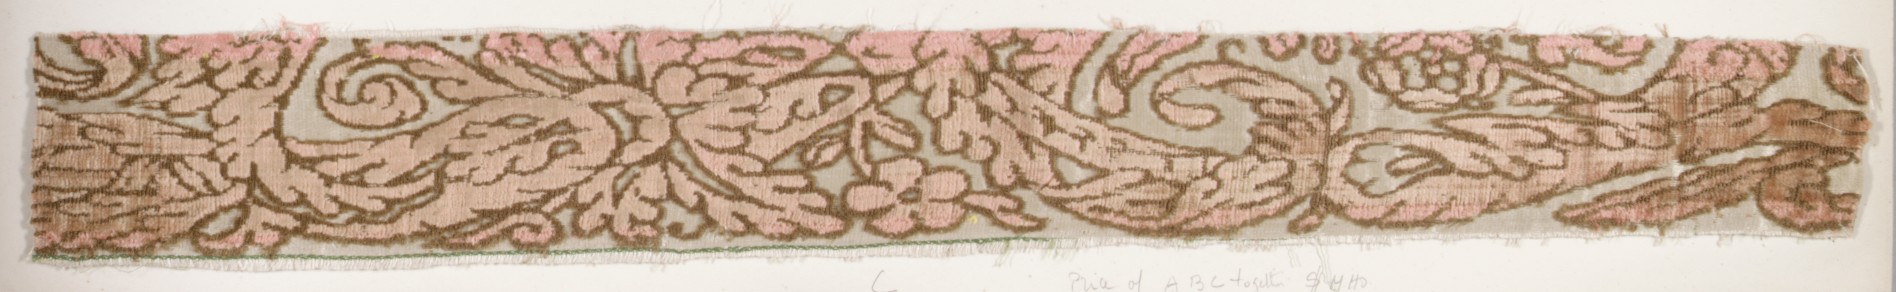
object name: fragment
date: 1667-1700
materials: silk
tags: flowers